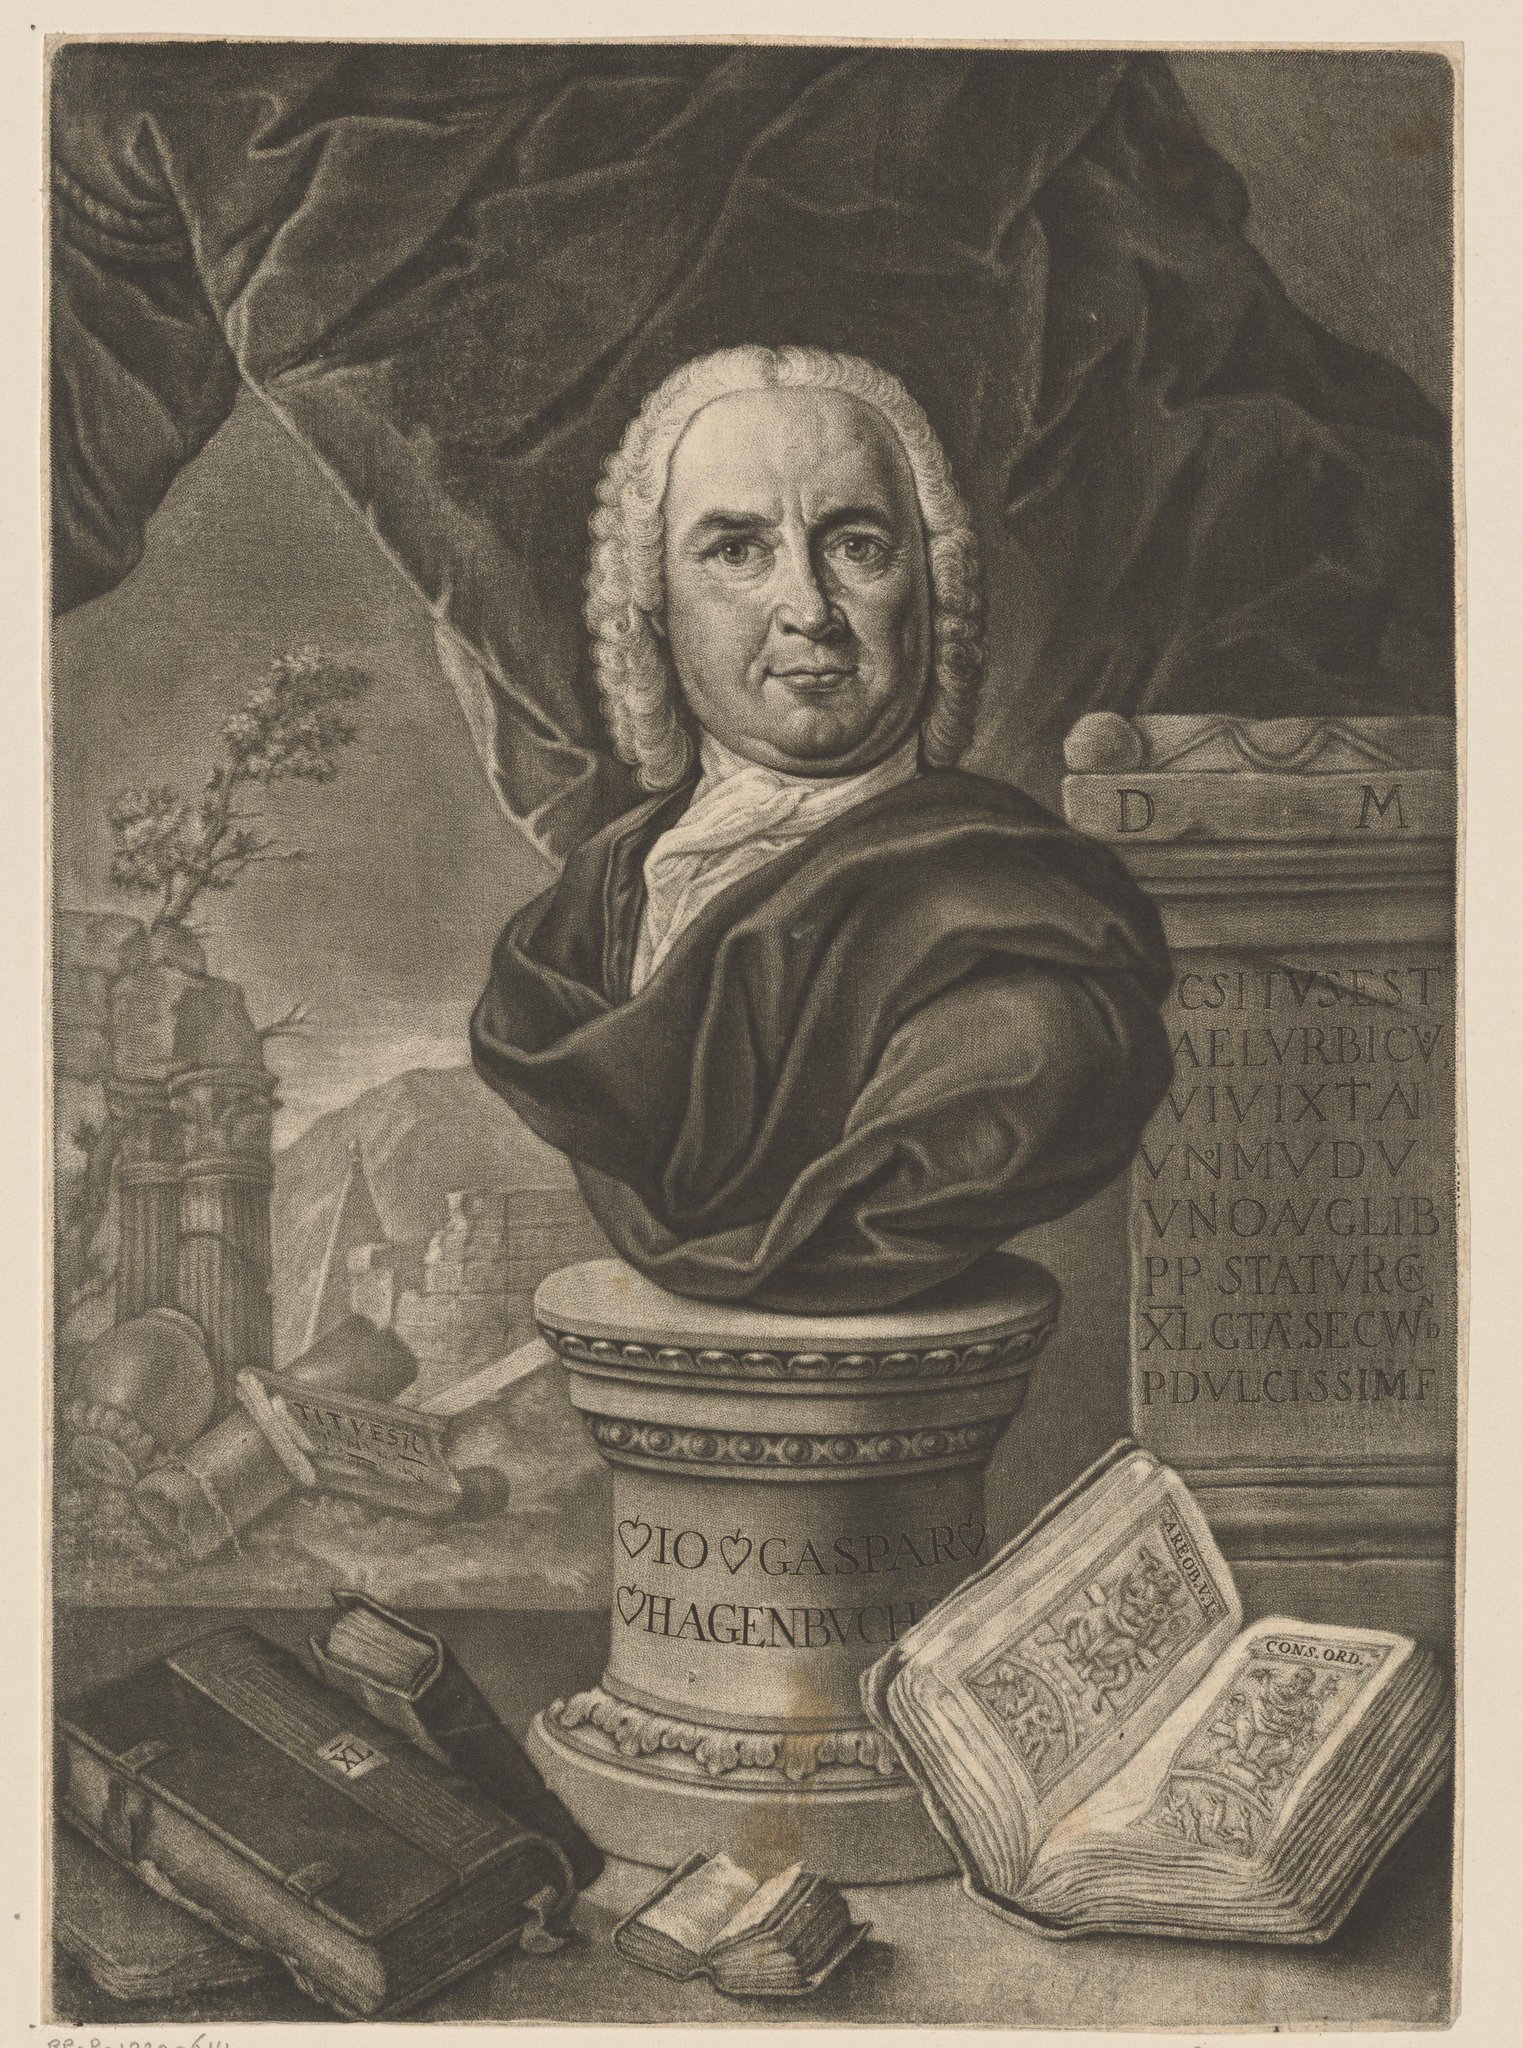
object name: print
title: Portret van Johann Kaspar Hagenbuch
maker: christian gottlieb geyser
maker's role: print maker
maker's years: 1742-1803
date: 1752-1803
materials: paper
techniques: engraving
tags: historical persons, landscape with ruins, book, printed matter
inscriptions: collector's mark: Lugt 2228